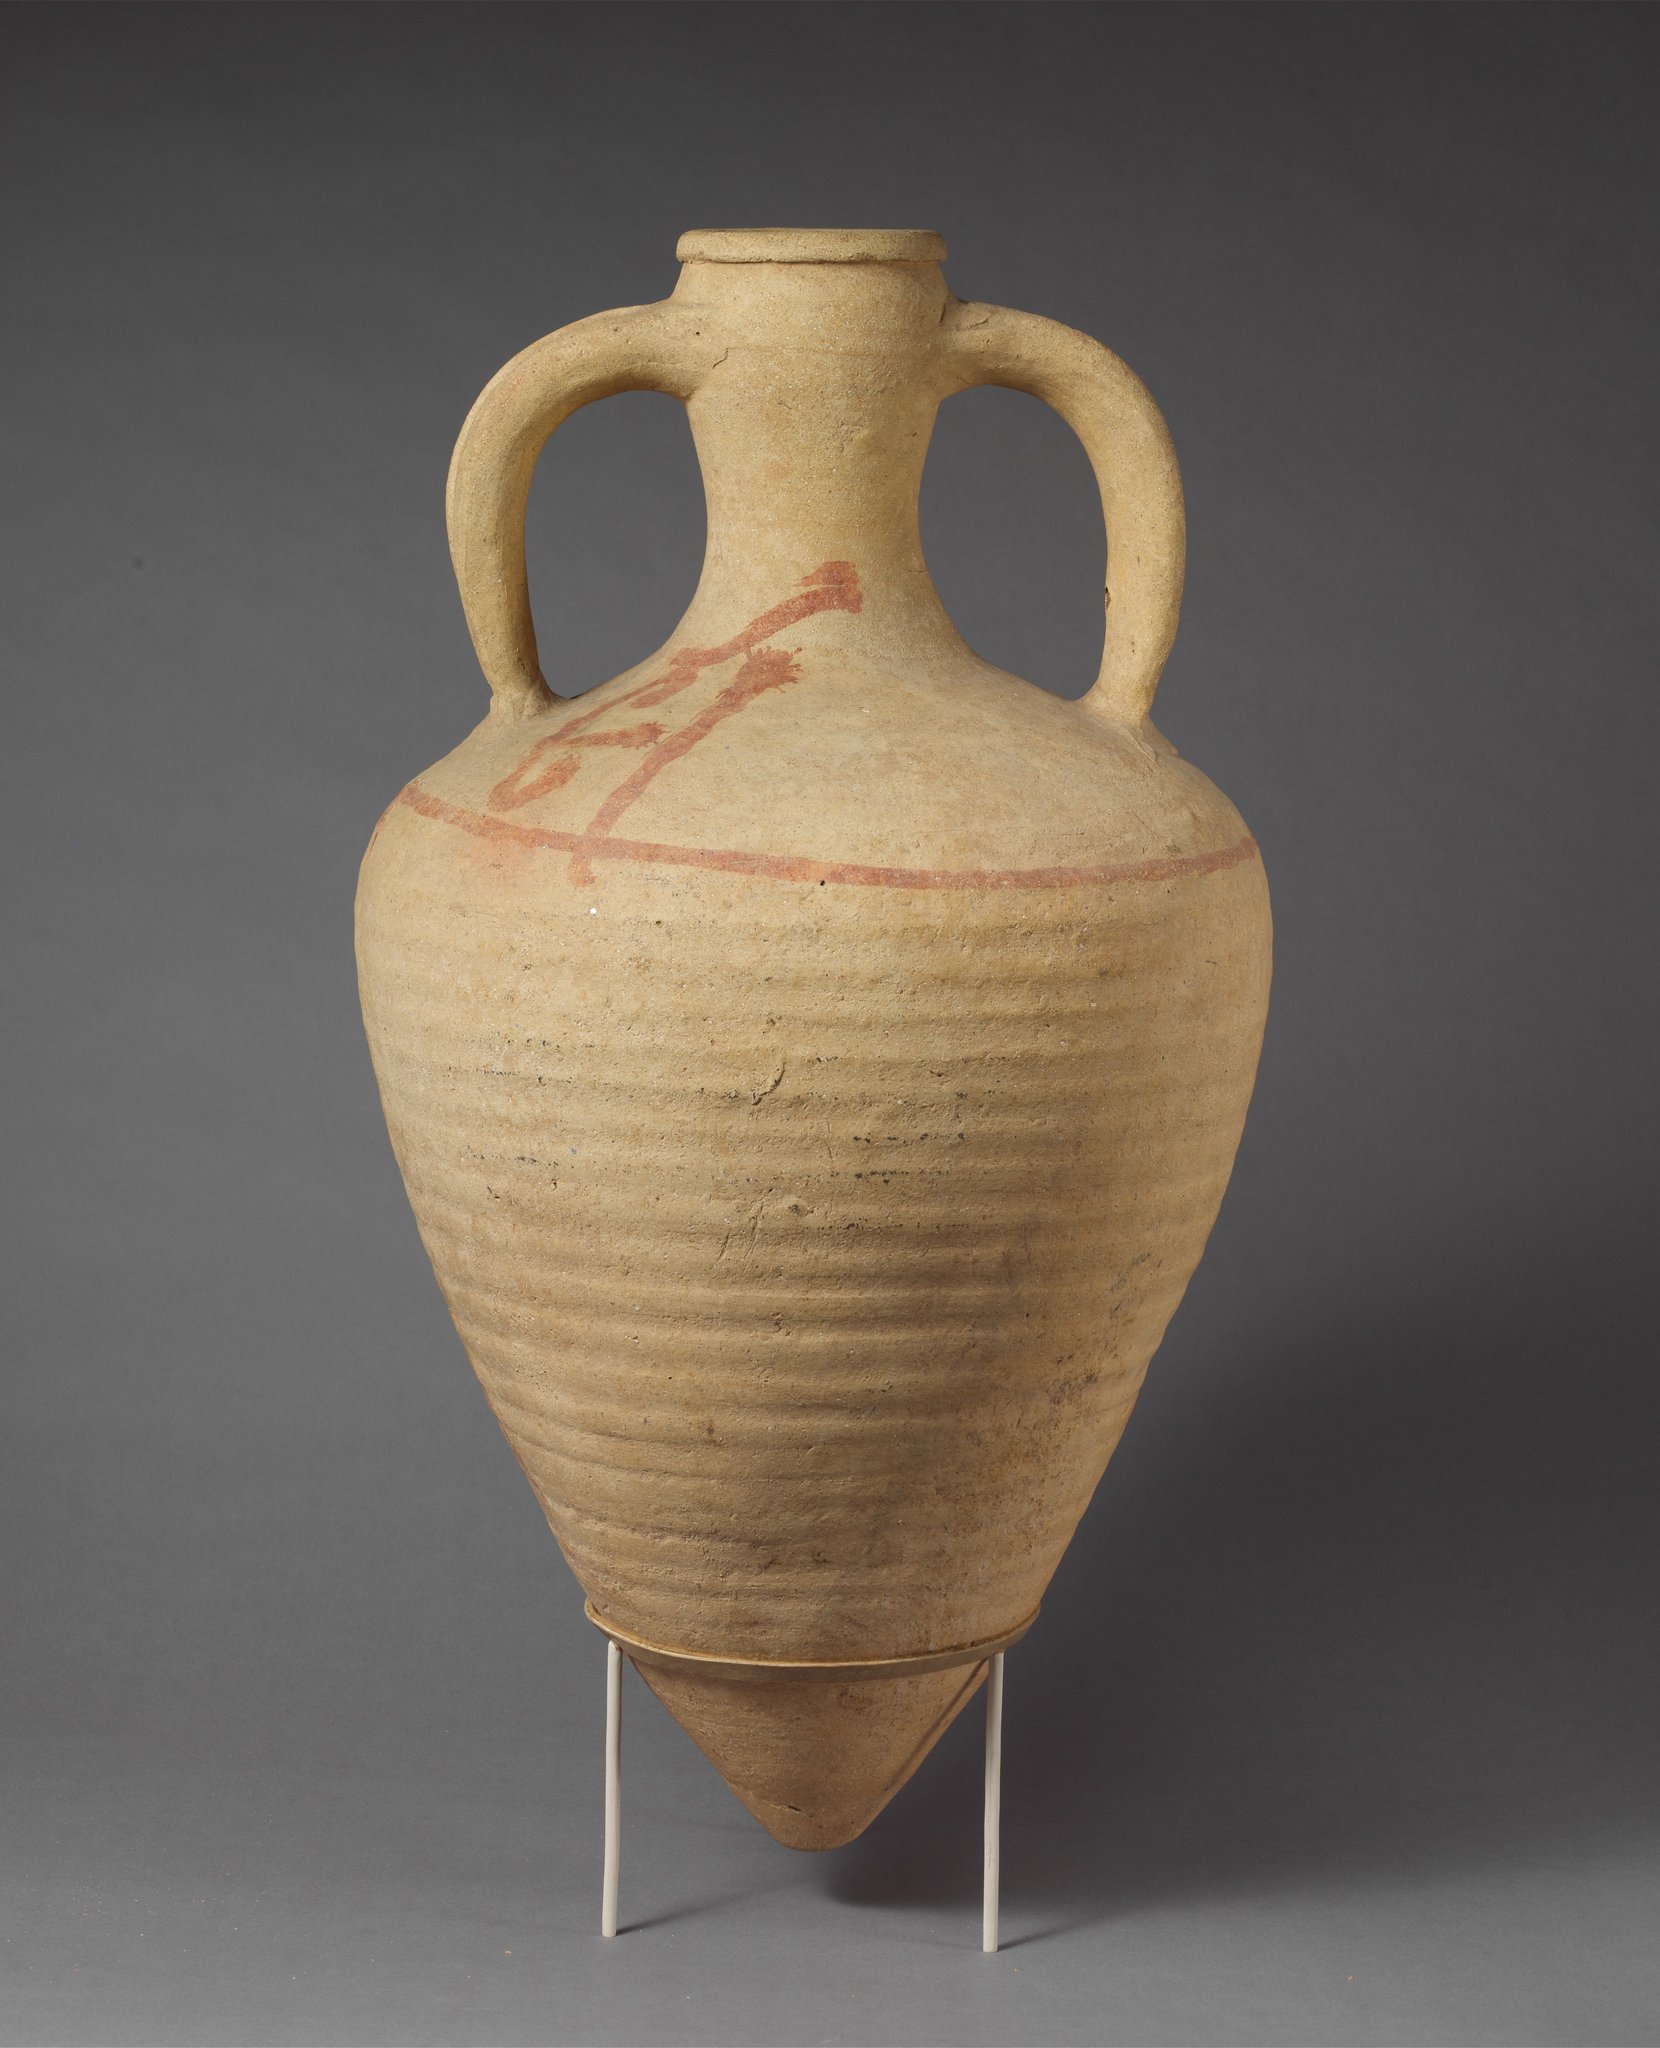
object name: amphora, inscribed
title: Terracotta amphora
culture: roman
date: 201-300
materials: terracotta